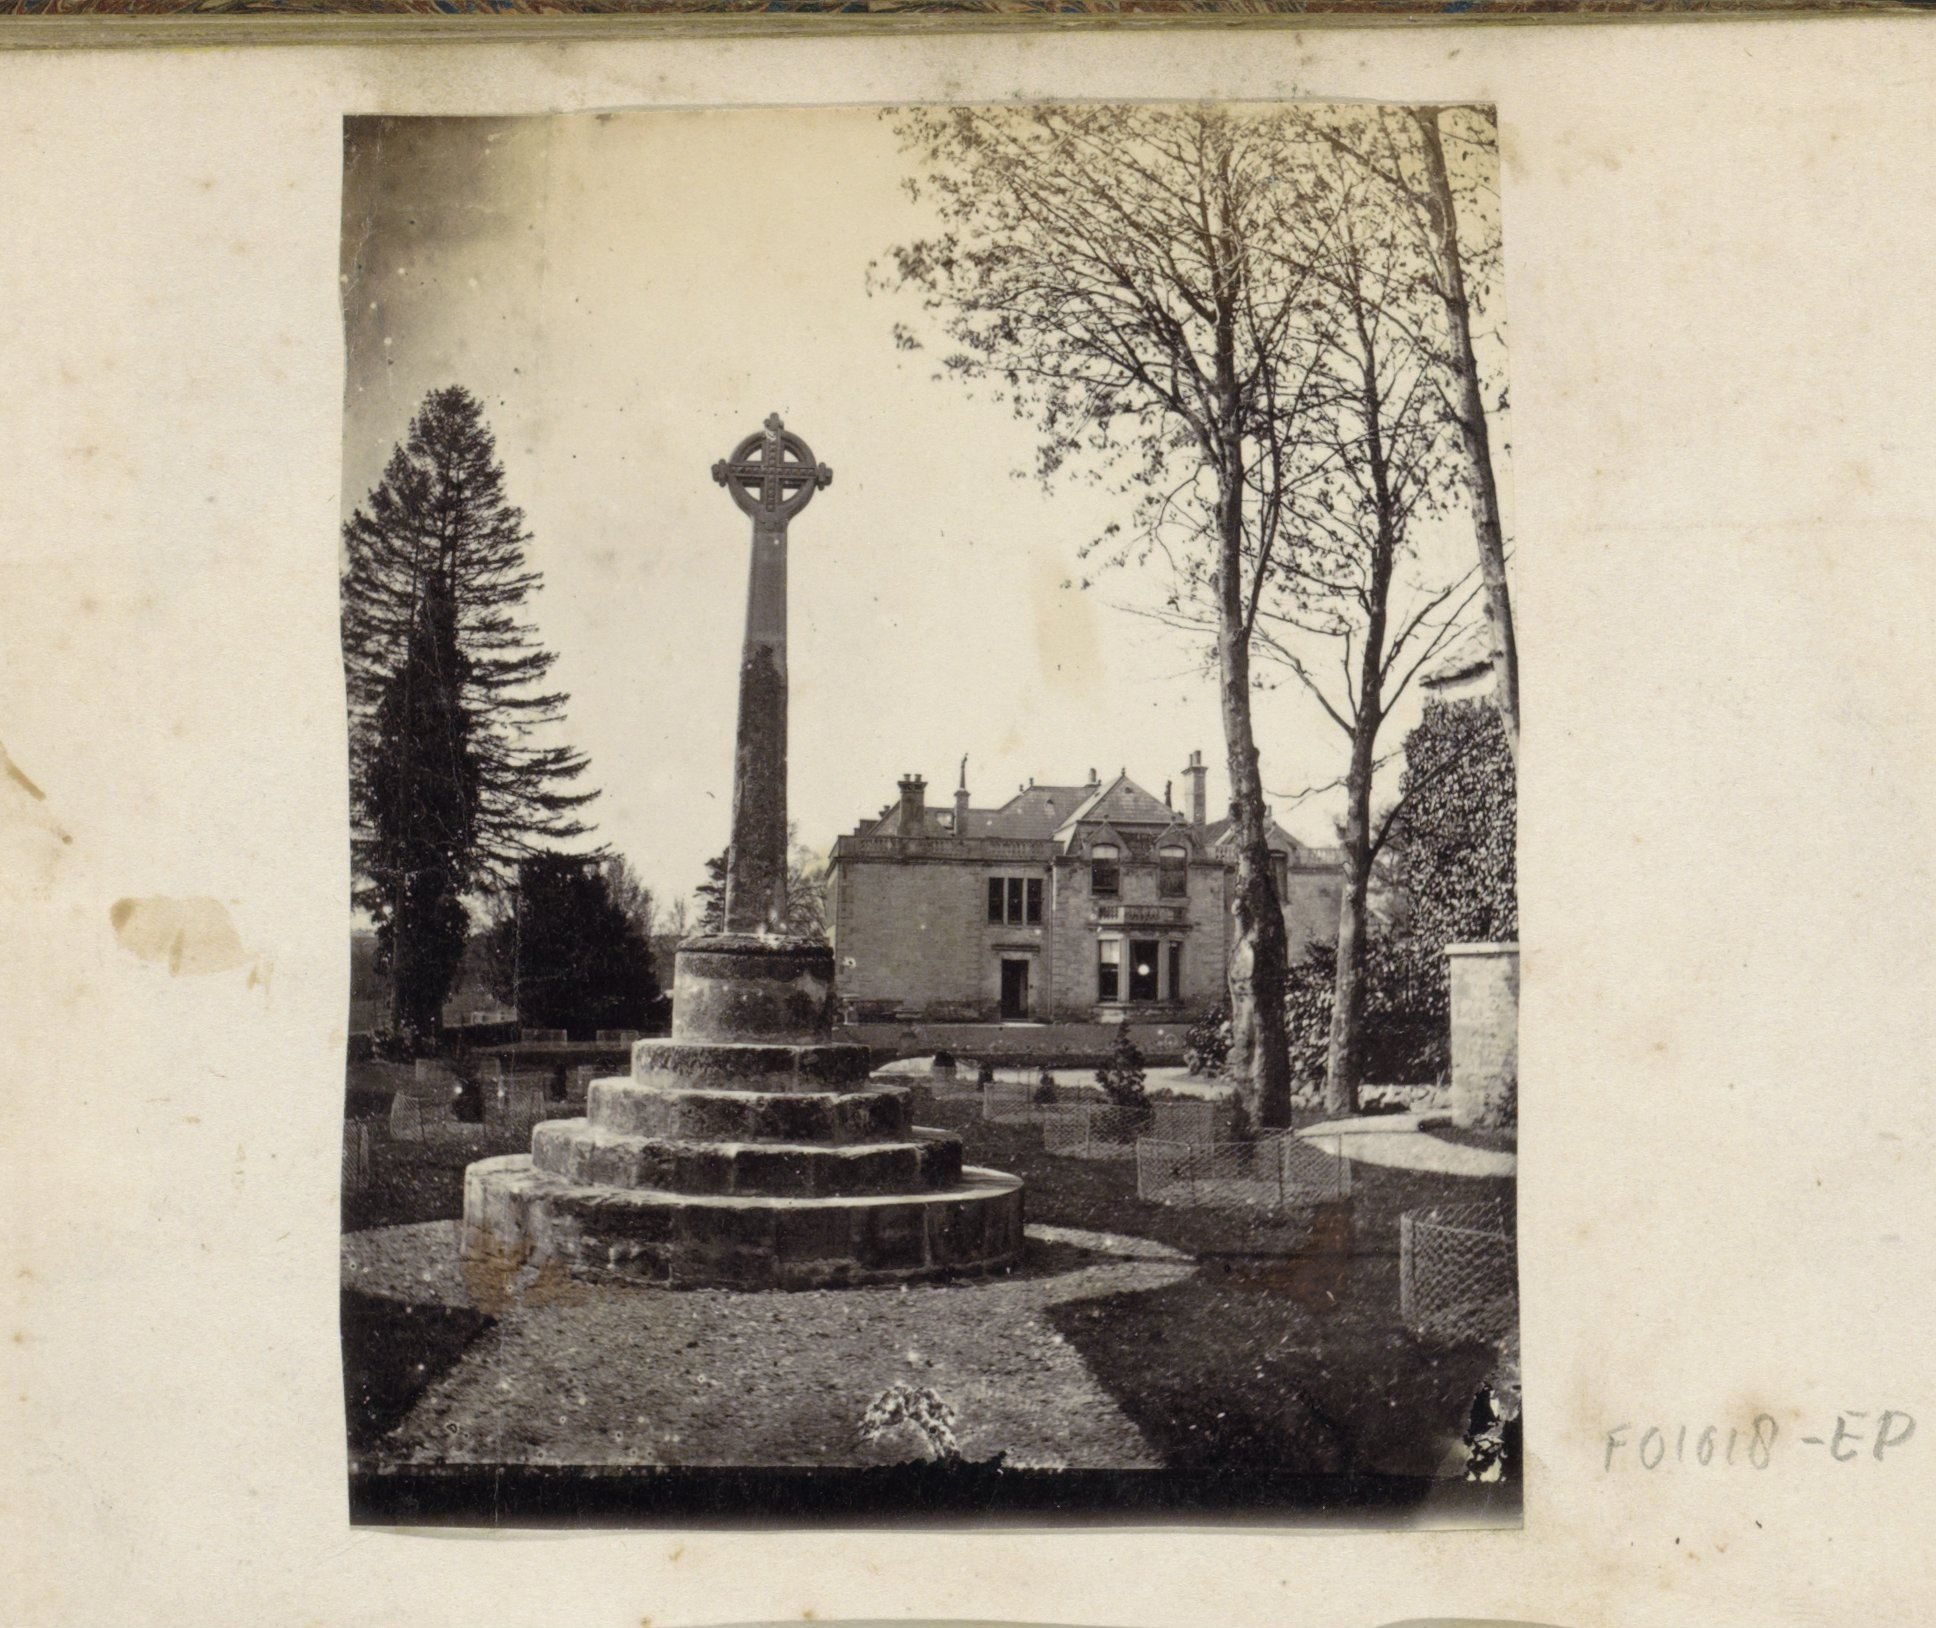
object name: photograph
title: Whatley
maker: Anonymous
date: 1860-1870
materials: paper, photographic support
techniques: albumen print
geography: whatley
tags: trees, places and objects of worship ~ celtic religion, rural housing, e.g. country-house, villa, cottage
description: Onderdeel van Engels familiealbum met foto's van personen, reizen, cricket en kunstwerken.